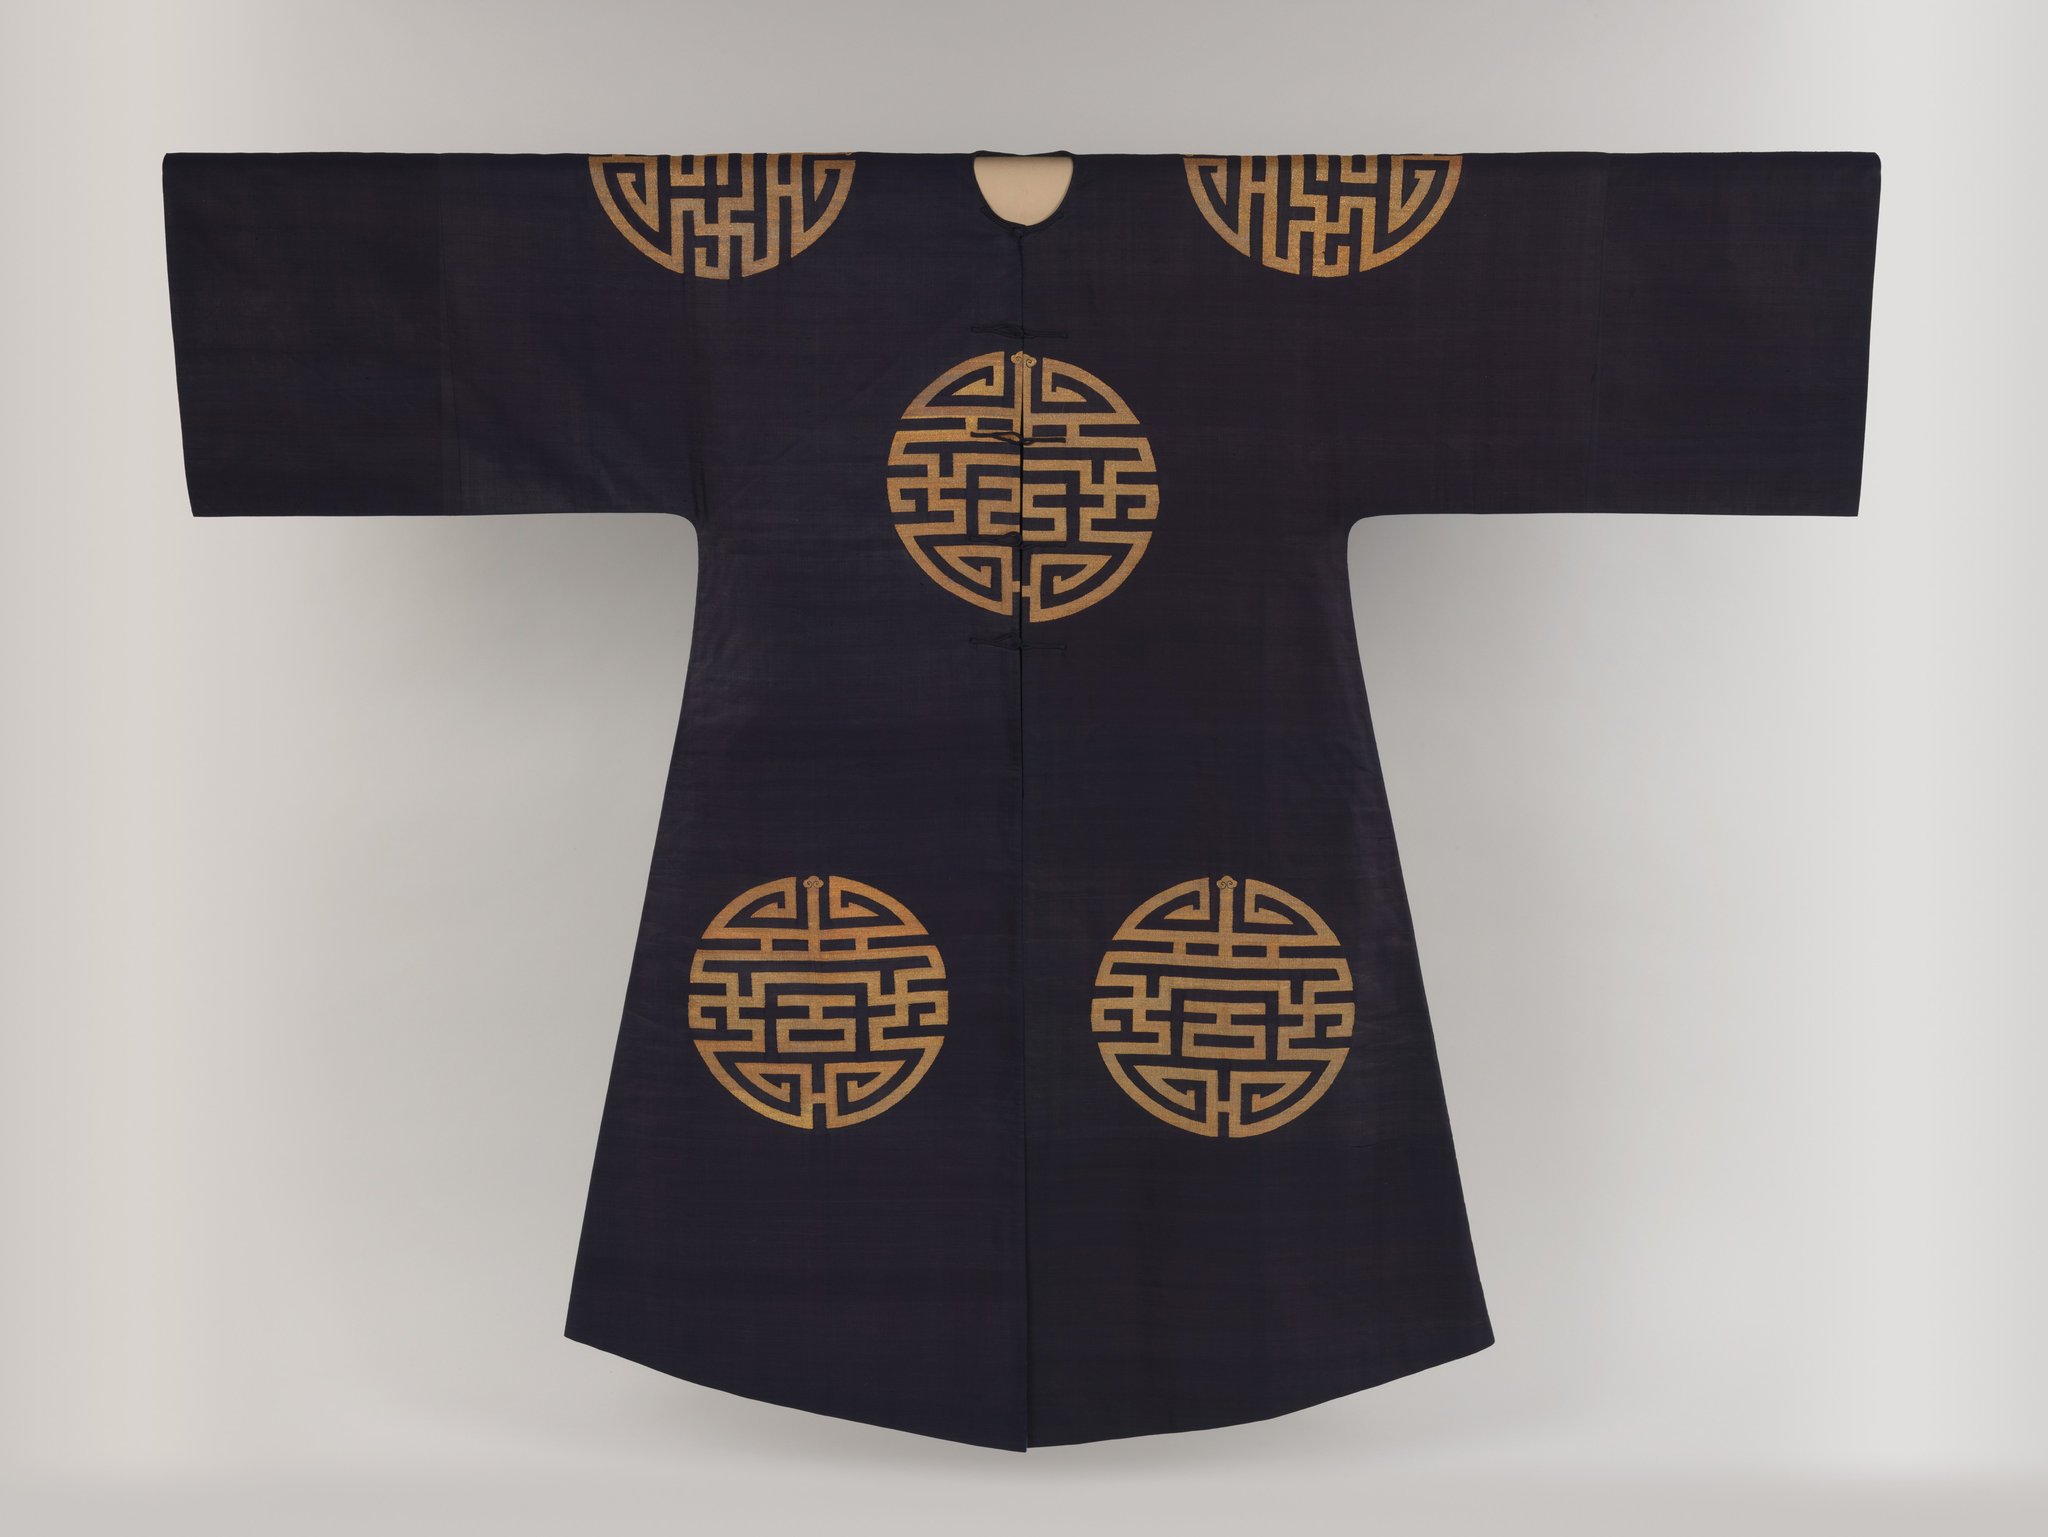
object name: coat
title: Woman's Ensemble of Robe and Coat with Shou Medallions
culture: chinese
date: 1801-1900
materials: metal thread, silk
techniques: tapestry